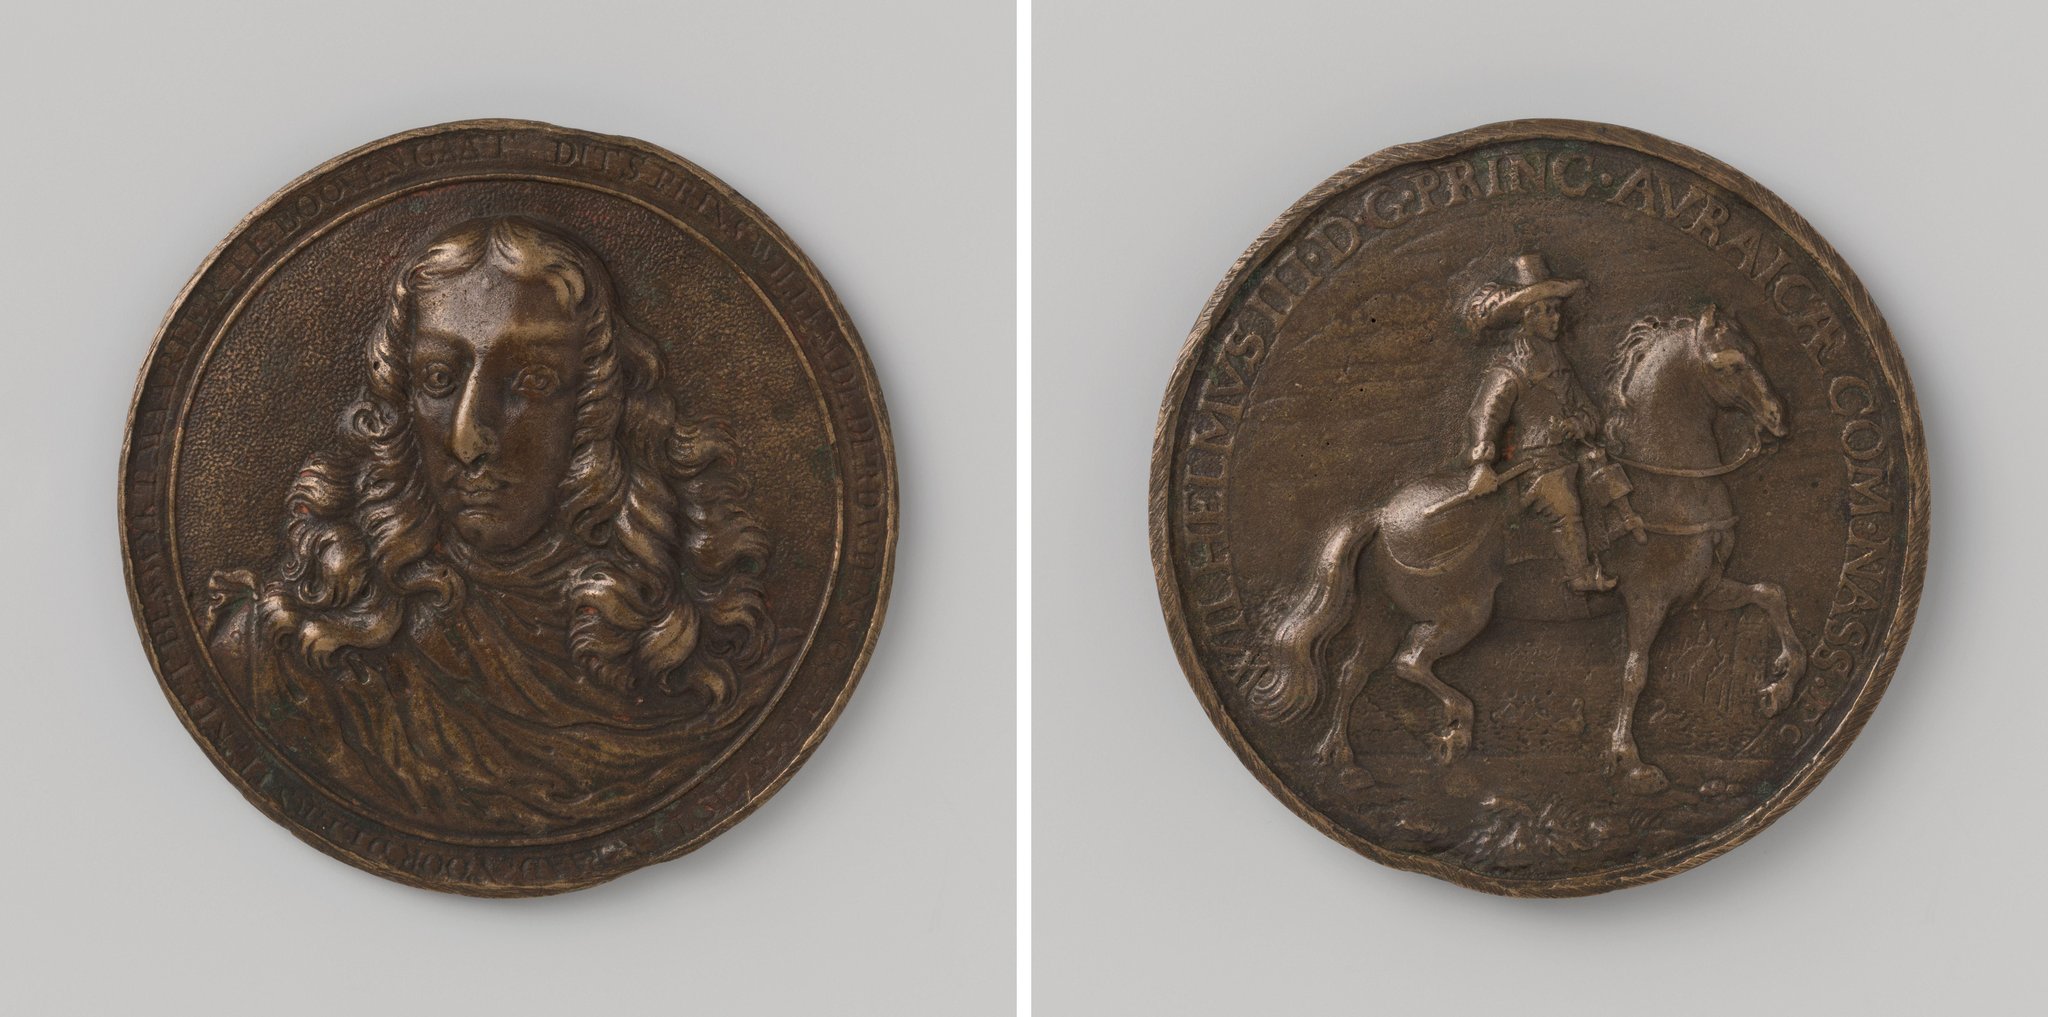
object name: history medal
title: Verheffing van Willem III tot opperbevelhebber van land-en zeemacht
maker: Anonymous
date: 1672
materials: bronze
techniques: striking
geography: netherlands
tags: william iii (prince of orange and king of england, scotland, and ireland)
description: Bronzen penning. Voorzijde: borststuk man. Keerzijde: portret man te paard met commandostaf binnen omschrift